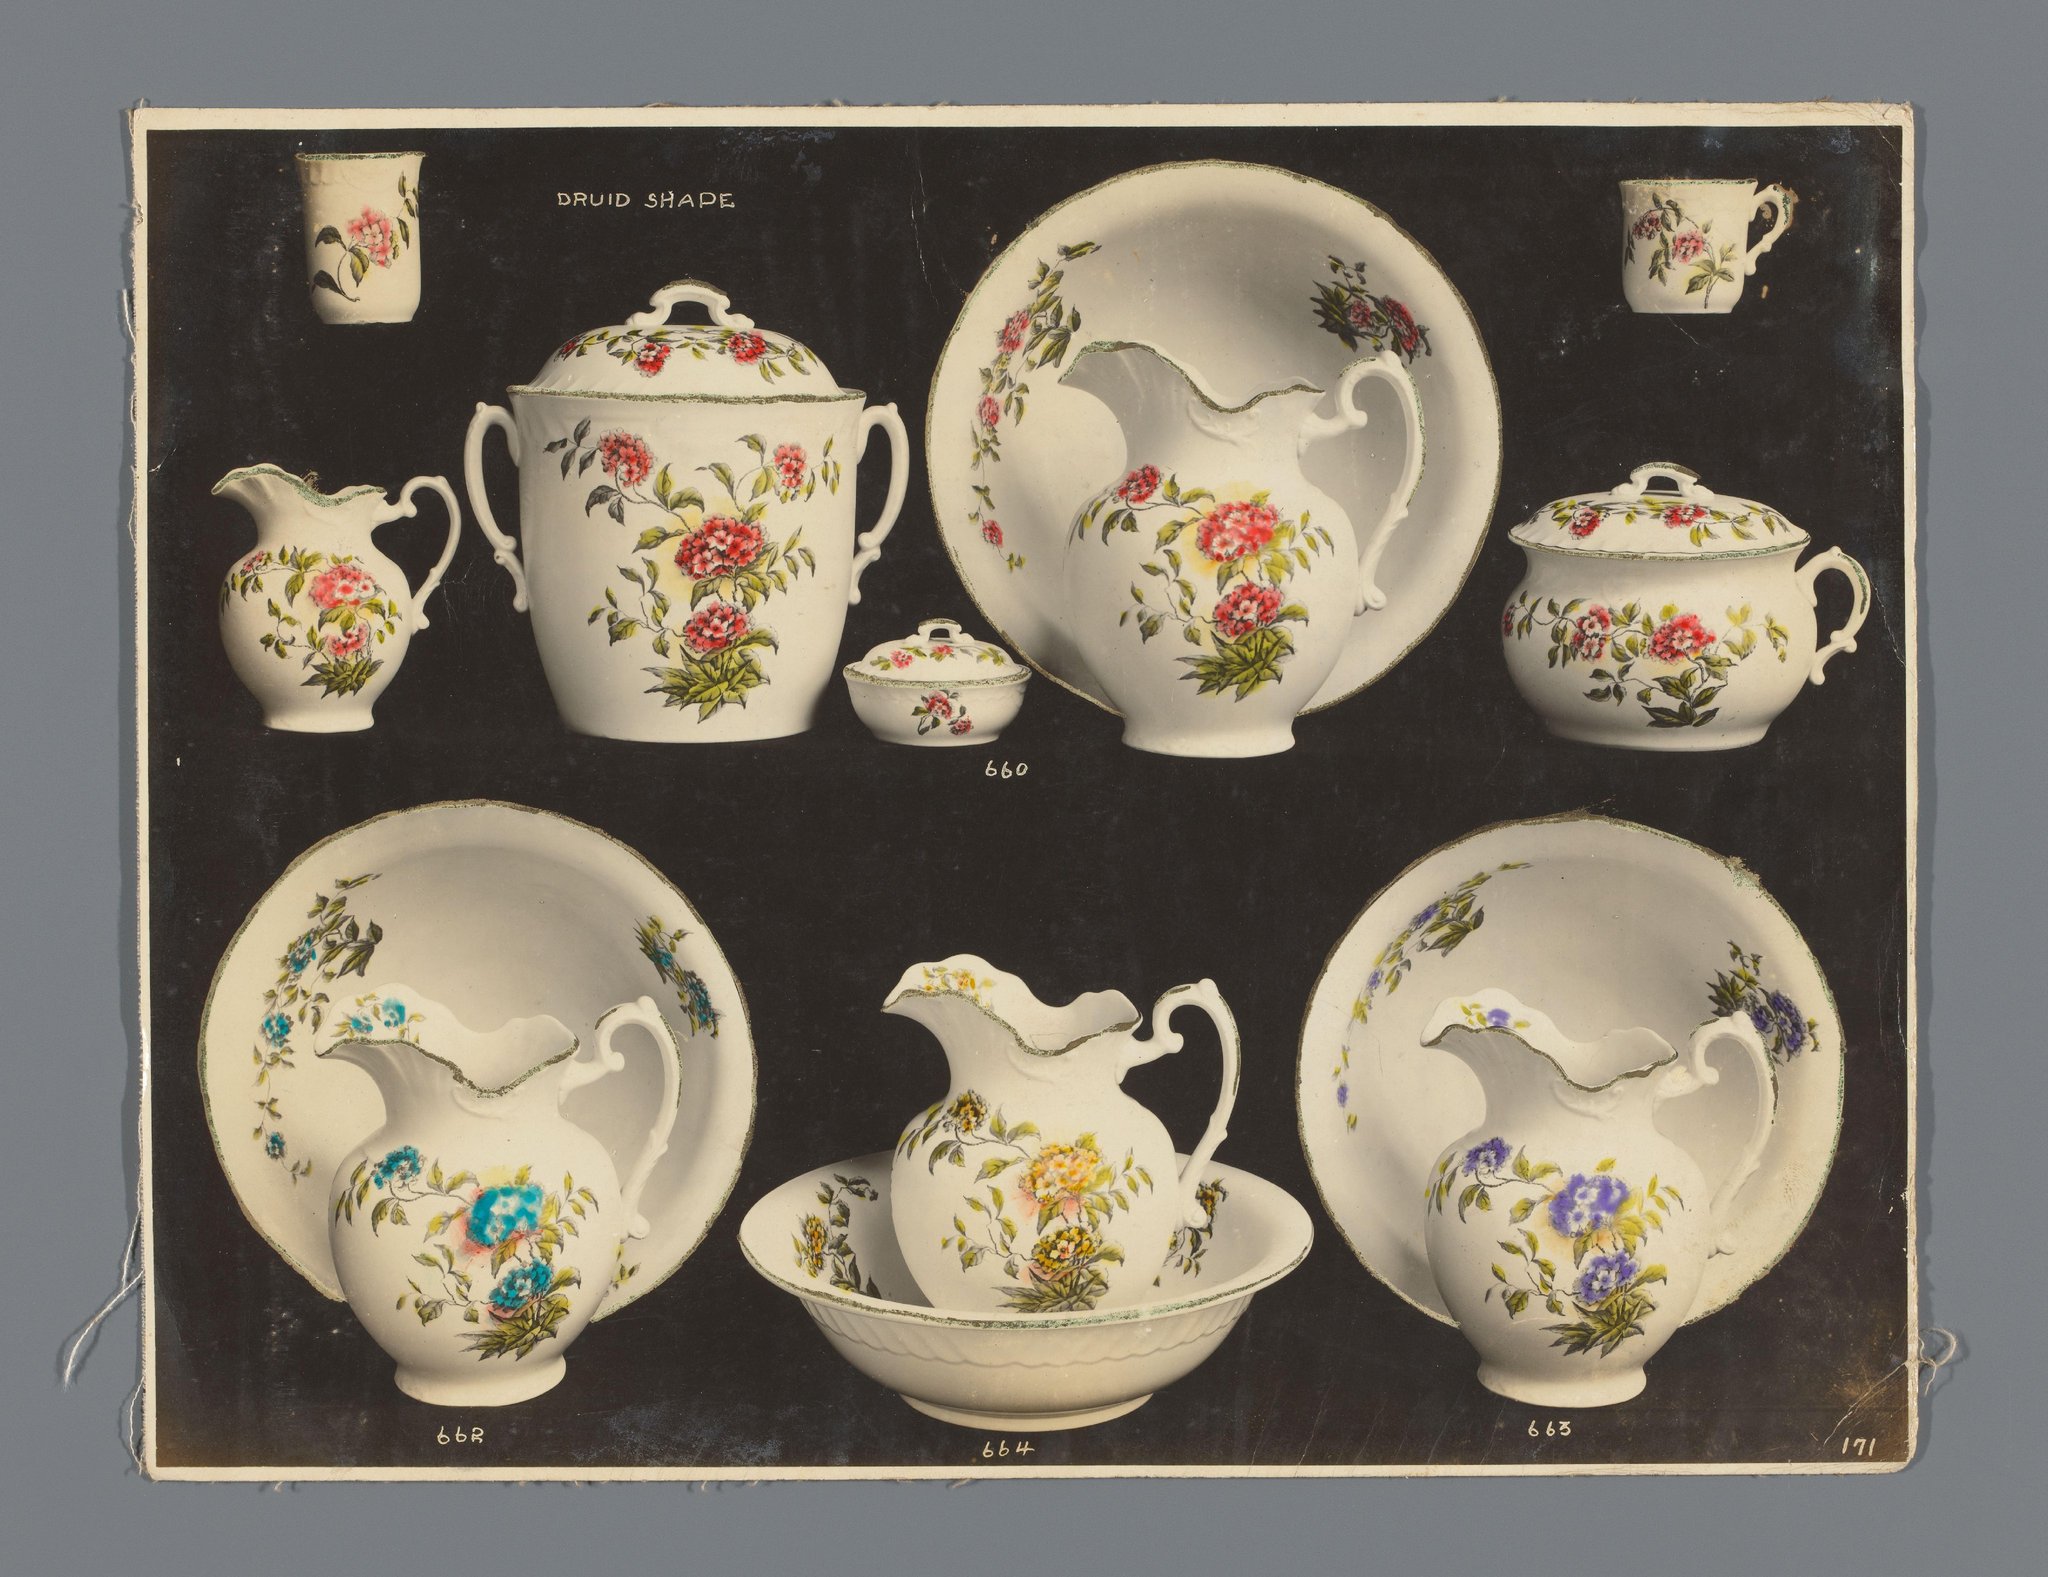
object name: photograph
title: Reclamefoto met serviezen en keukengerei van de firma C. Read & Co., Baltimore, Maryland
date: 1920-1930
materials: paper, textile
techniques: photography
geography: united states